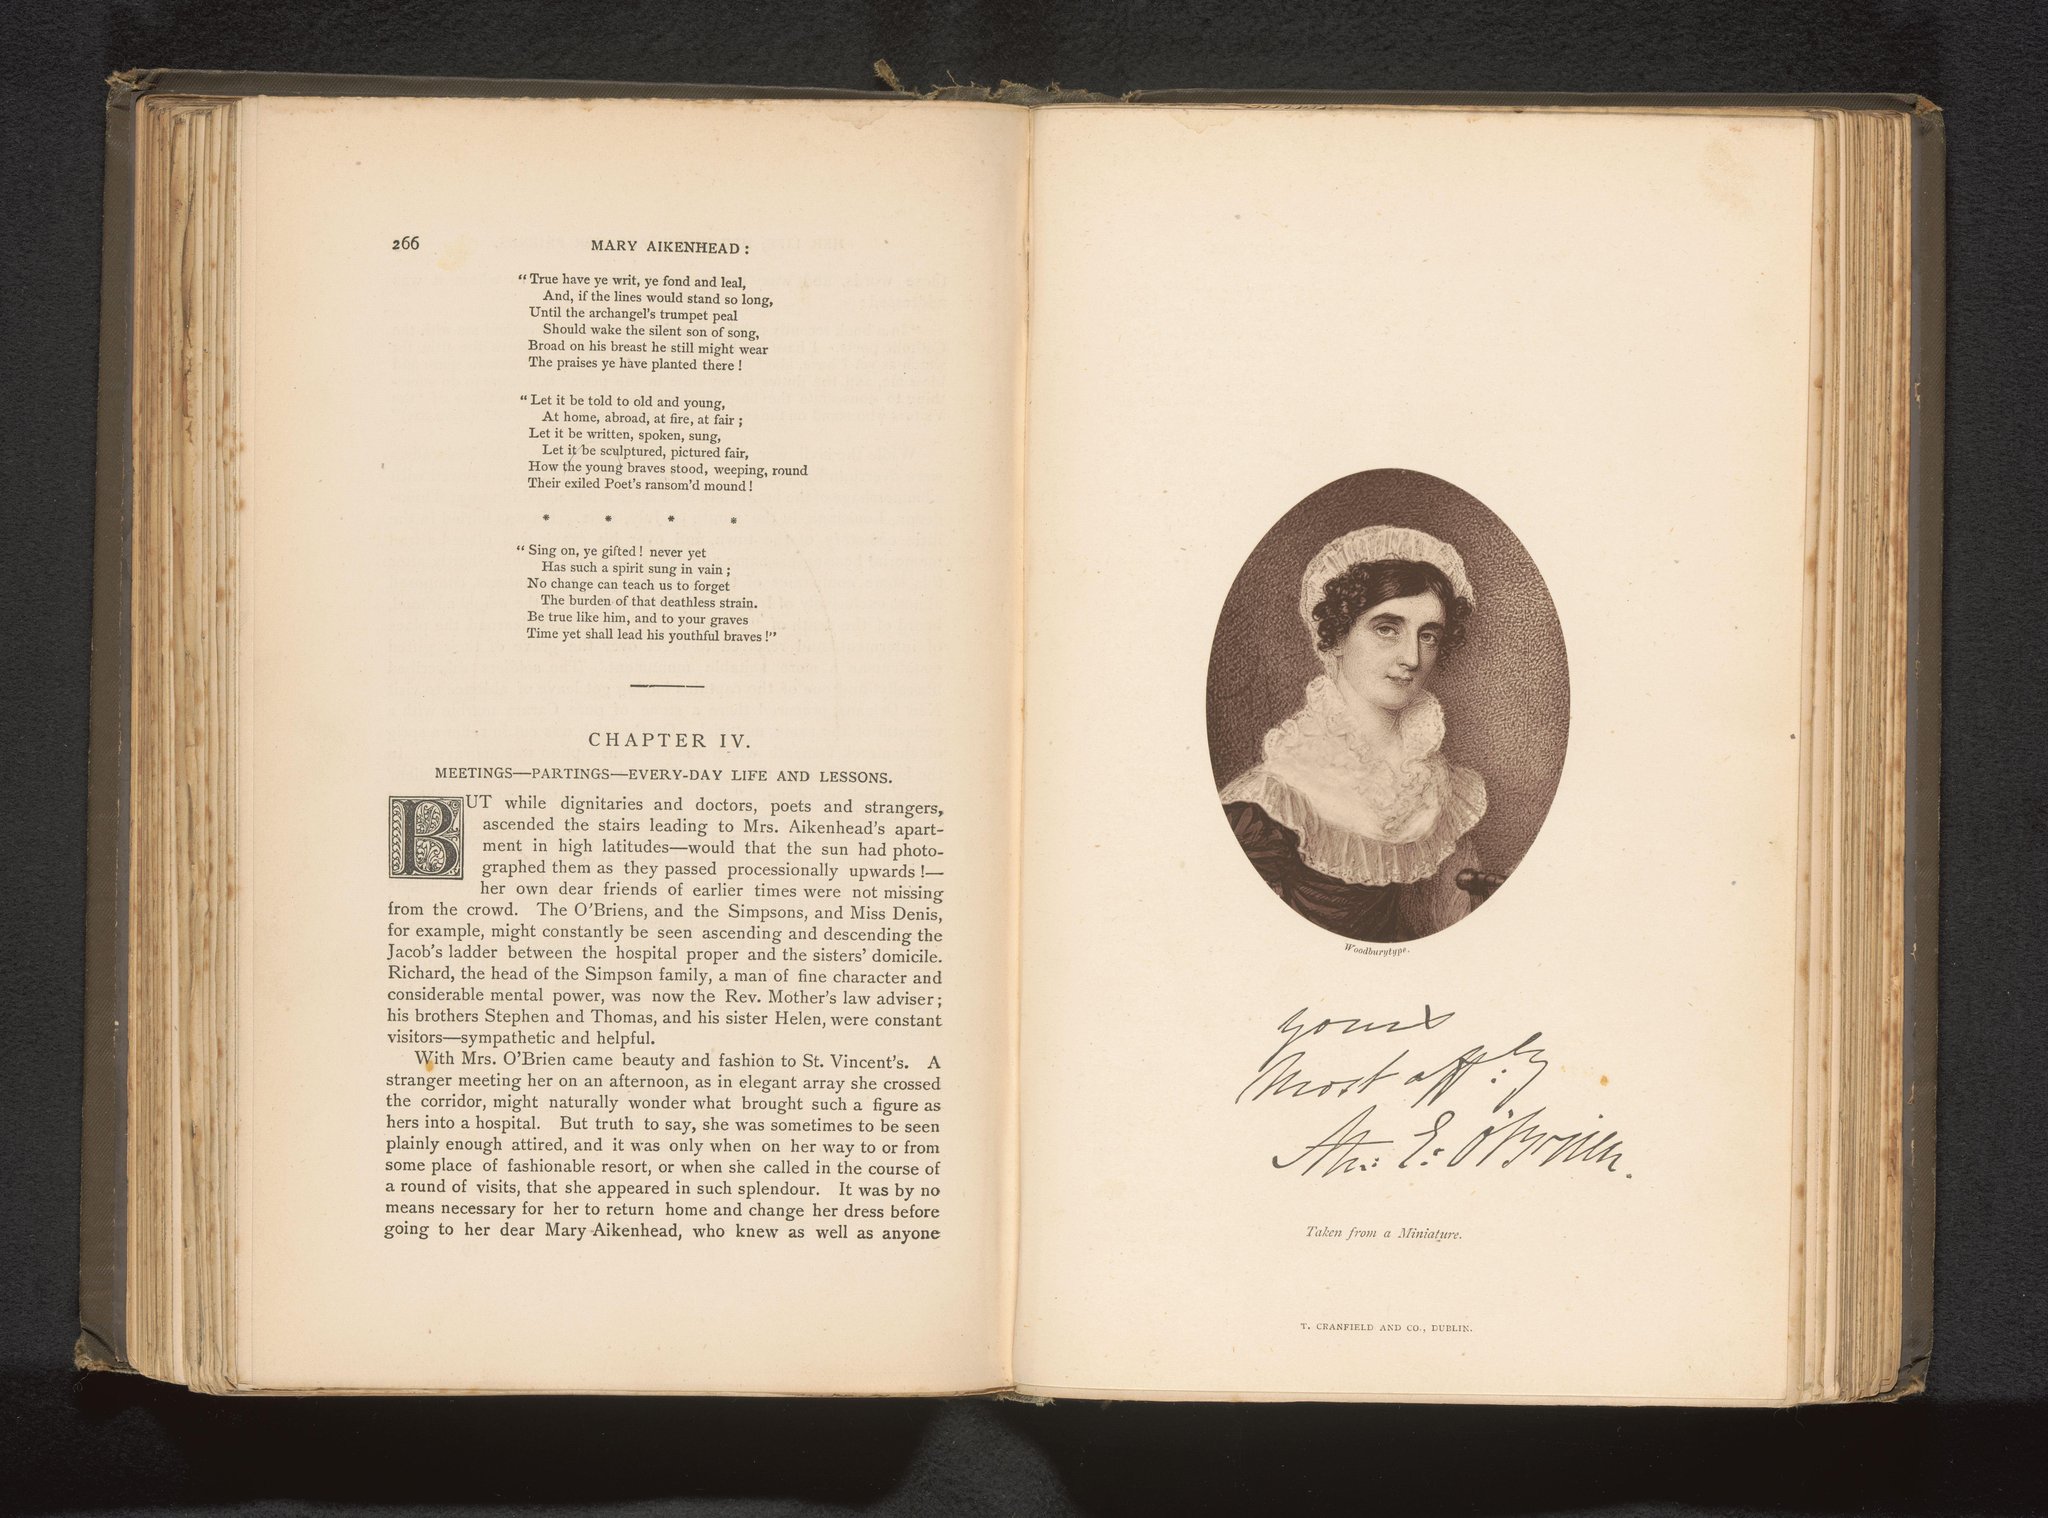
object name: photomechanical print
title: Fotoreproductie van een schilderij, voorstellende een portret van Mary Aikenhead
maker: Anonymous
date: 1869-1879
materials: paper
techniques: woodburytype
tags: organization, functionaries and dignitaries in roman catholic church; clergy in general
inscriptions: inscription: ‘yours most affly [...]’